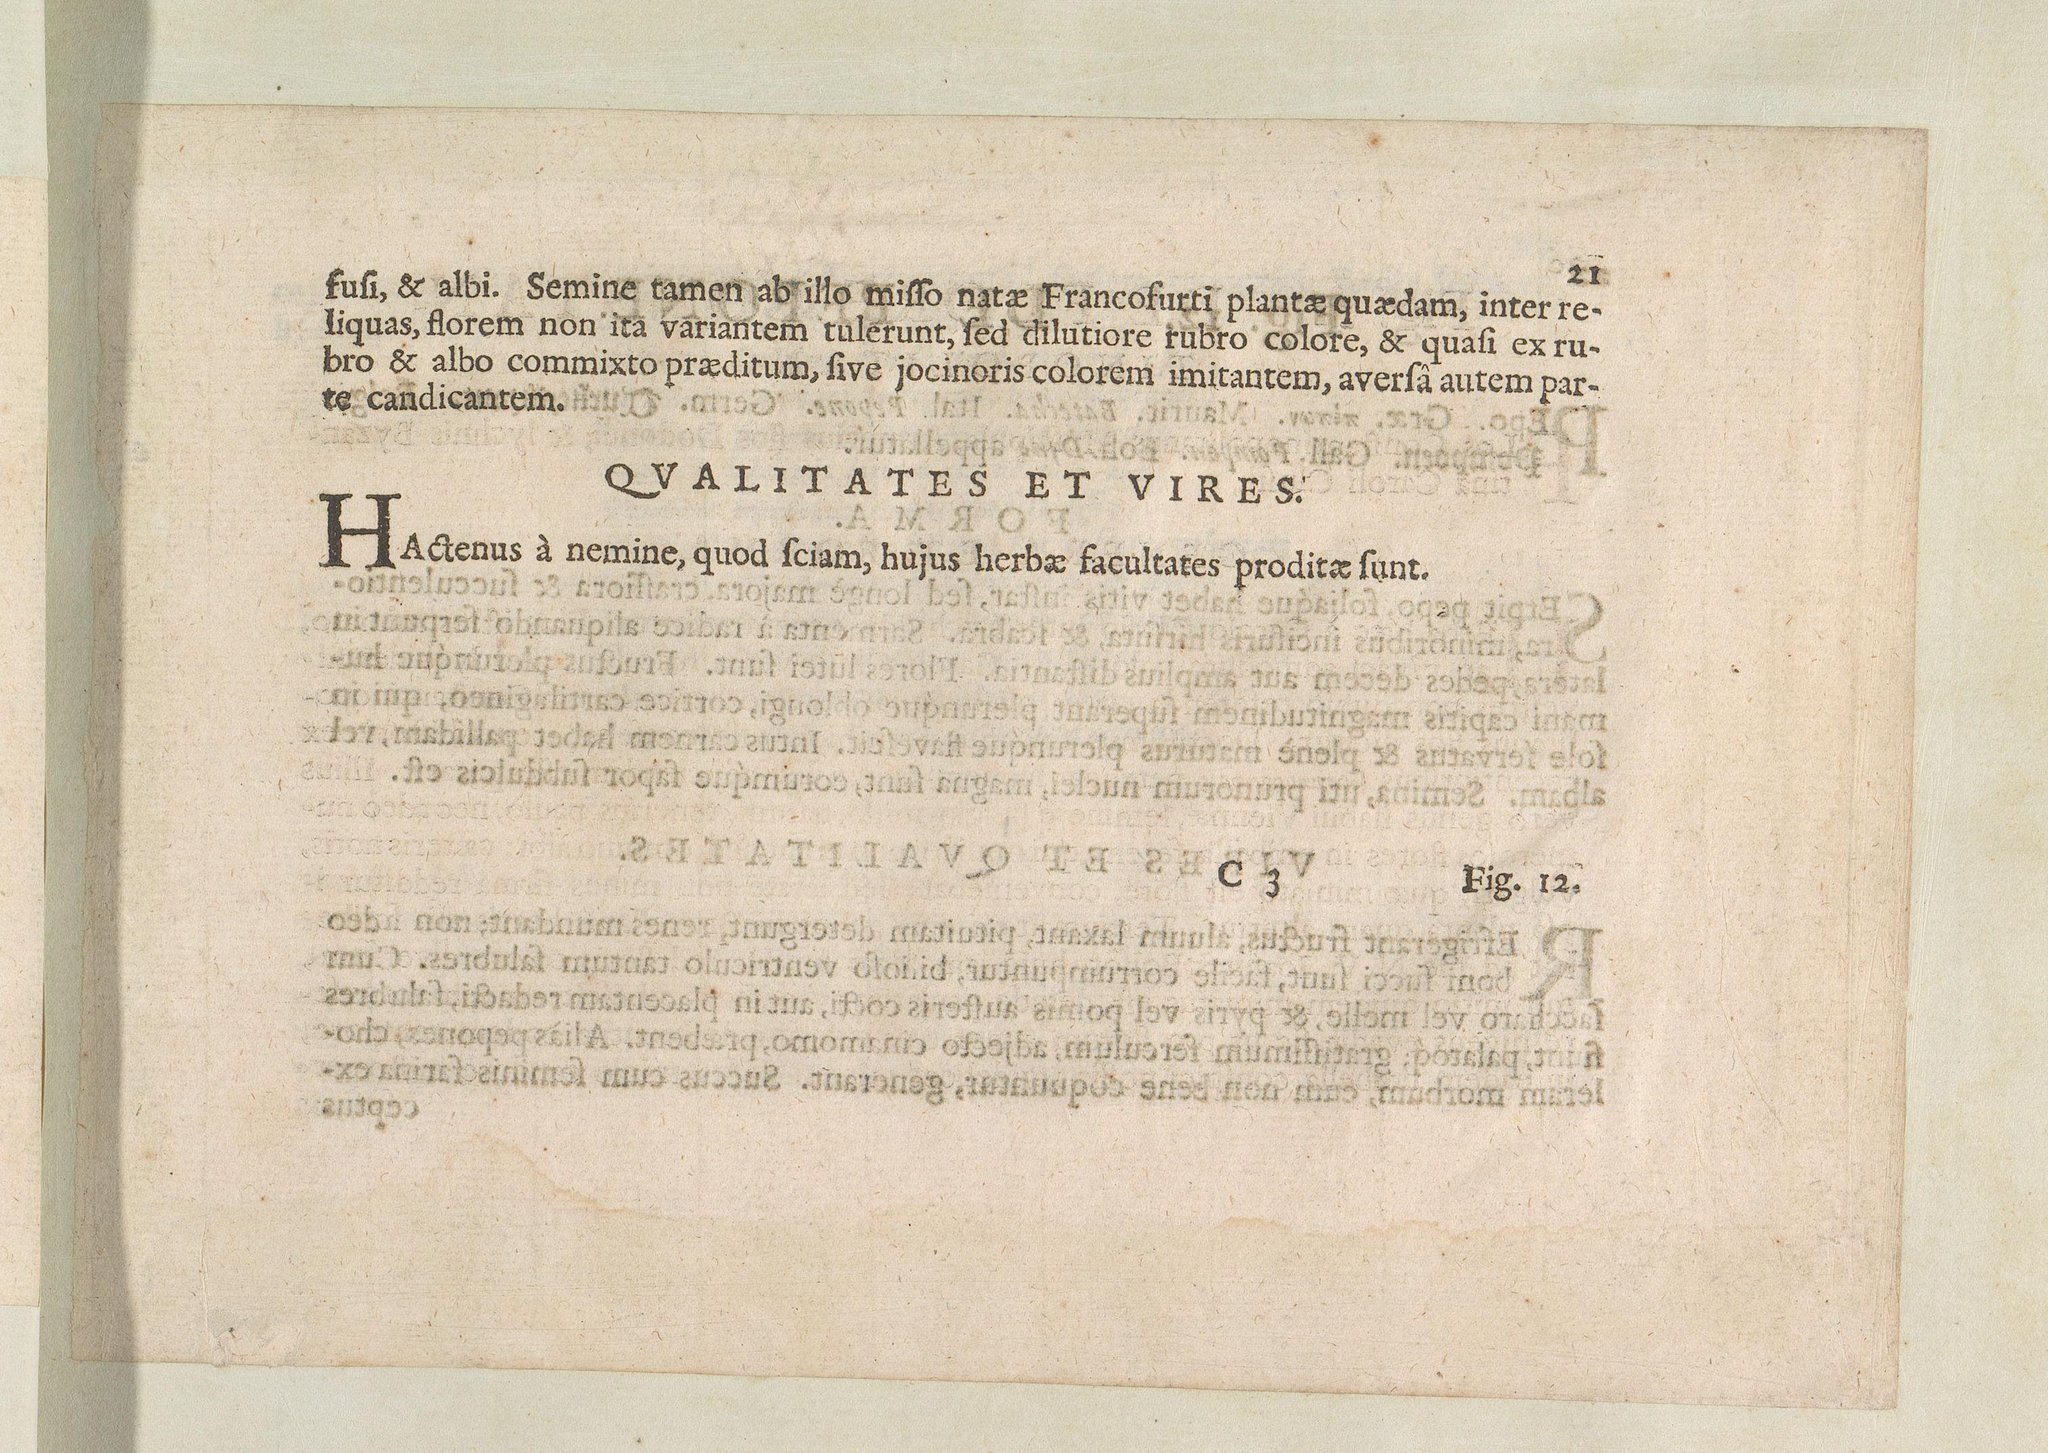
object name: text sheet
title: Fig. 11 'De Flore Constantinopolitano' in De Boodts herbarium van 1640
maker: anselmus boëtius de boodt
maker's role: draughtsman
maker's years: 1550-1632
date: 1640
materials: ink, paper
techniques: letterpress printing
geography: bruges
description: Beschrijving bij Fig. 11 op p. 21 in: Anselmi Boëtii de Boot I.C. Brugensis & Rodolphi II. Imp. Roman. medici a cubiculis Florum, Herbarum, ac fructuum selectiorum icones, & vires pleraeque hactenus ignotæ. Onderdeel van het album met bladen en platen uit De Boodts herbarium van 1640. Het twaalfde van twaalf albums met aquarellen van dieren, vogels en planten bekend rond 1600, gemaakt in opdracht van keizer Rudolf II.